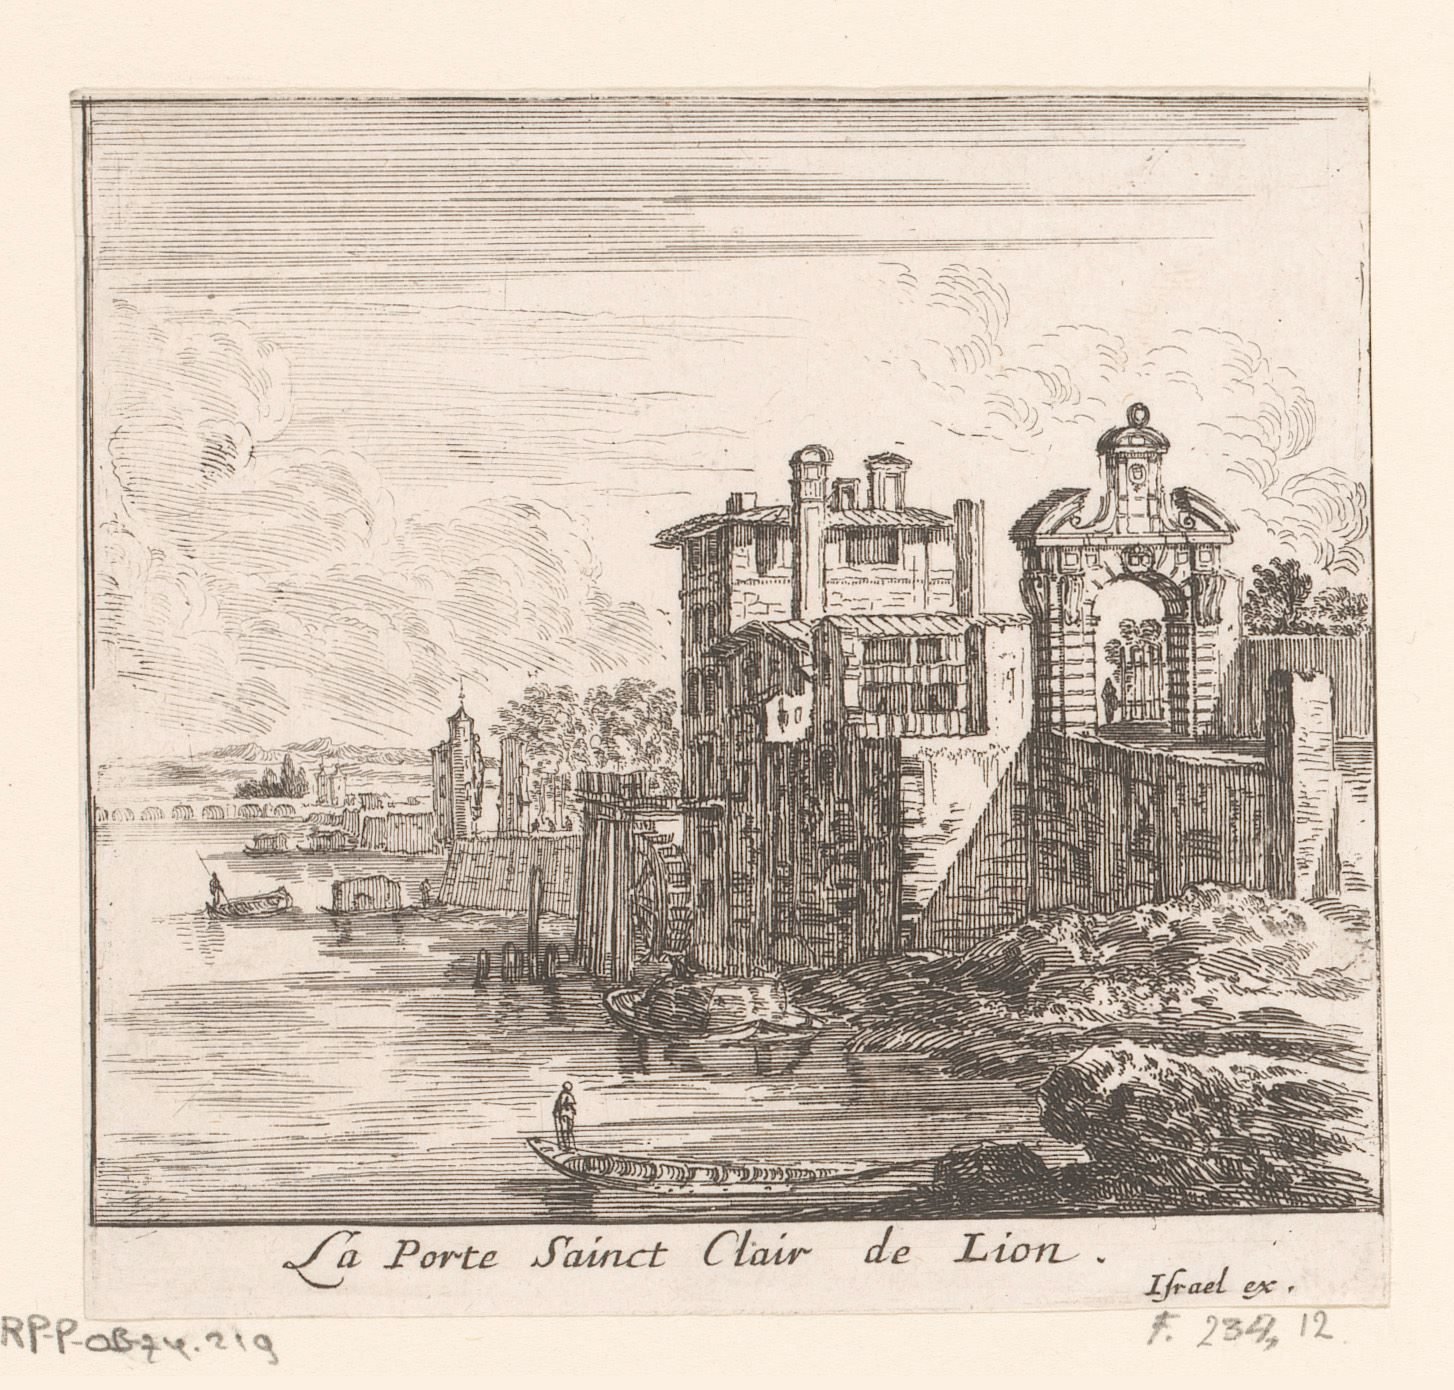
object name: print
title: Diverse gezichten op Lyon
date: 1652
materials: paper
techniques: engraving, etching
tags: city-view, and landscape with man-made constructions, lyon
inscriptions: collector's mark: Lugt 240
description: Prent maakt deel uit van een ongenummerde serie van dertien prenten.